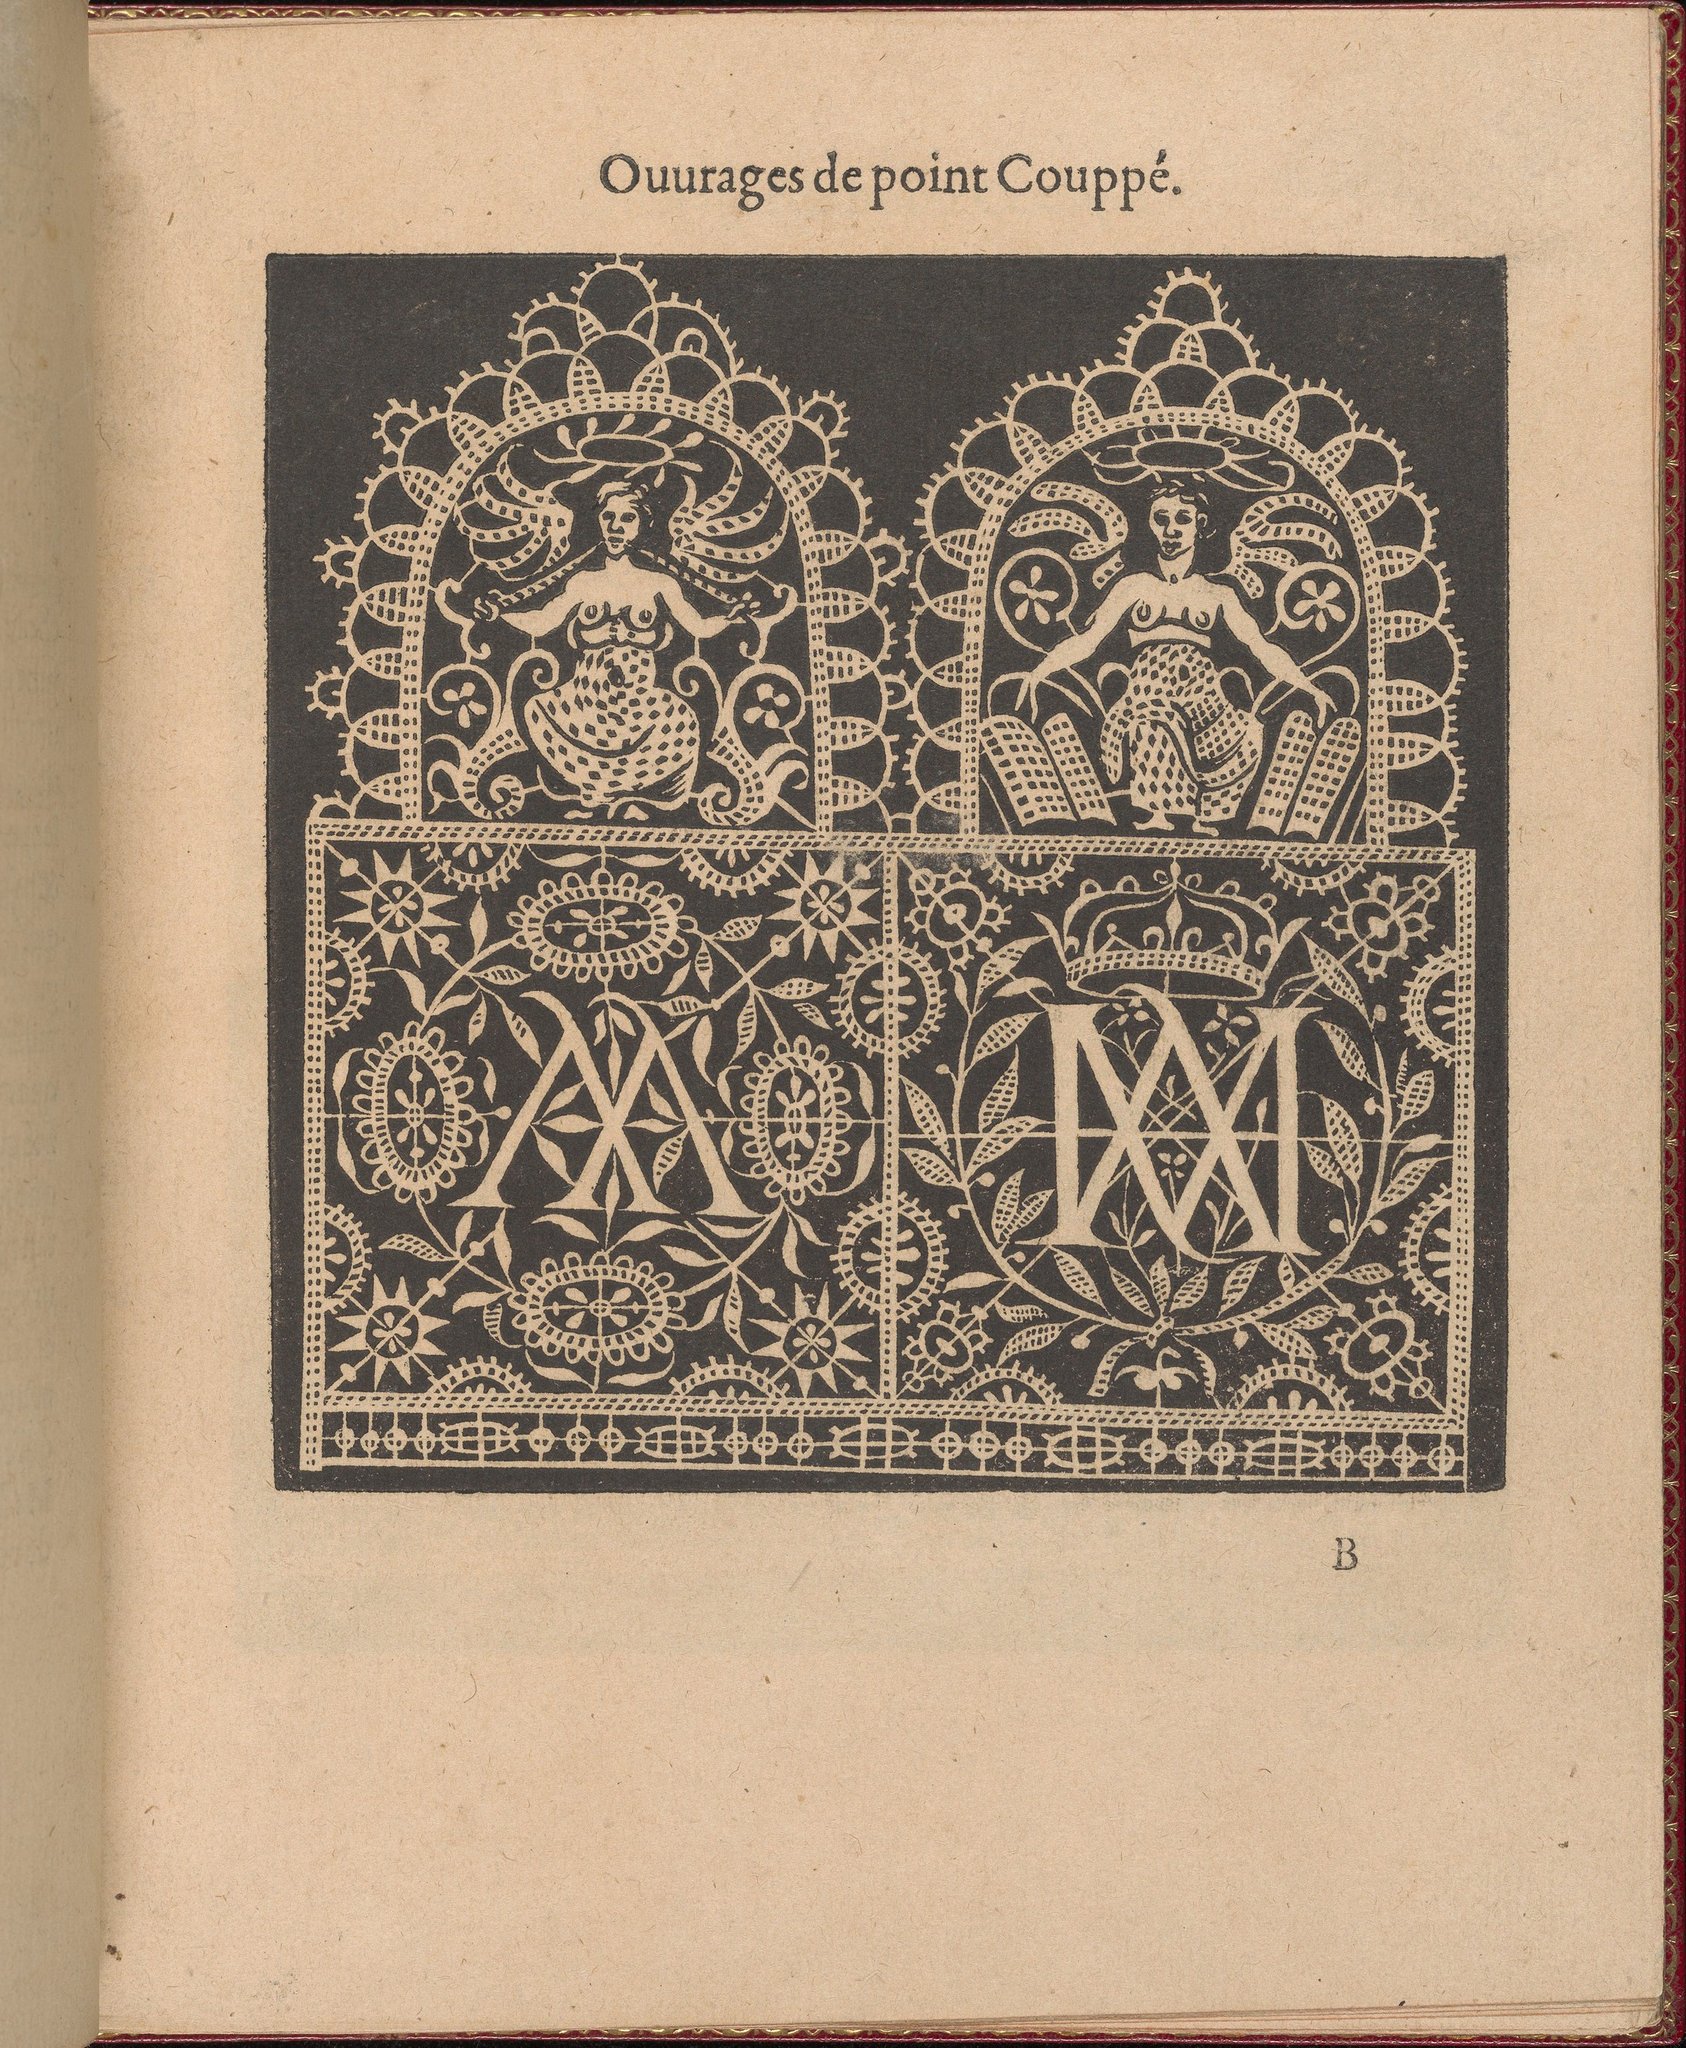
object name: book print ornament architecture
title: Les Singuliers et Nouveaux Portraicts... page 5 (recto)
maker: federico de vinciolo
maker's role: designer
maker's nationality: italian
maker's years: 1582-1599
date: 1588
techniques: woodcut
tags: ornament,insignia